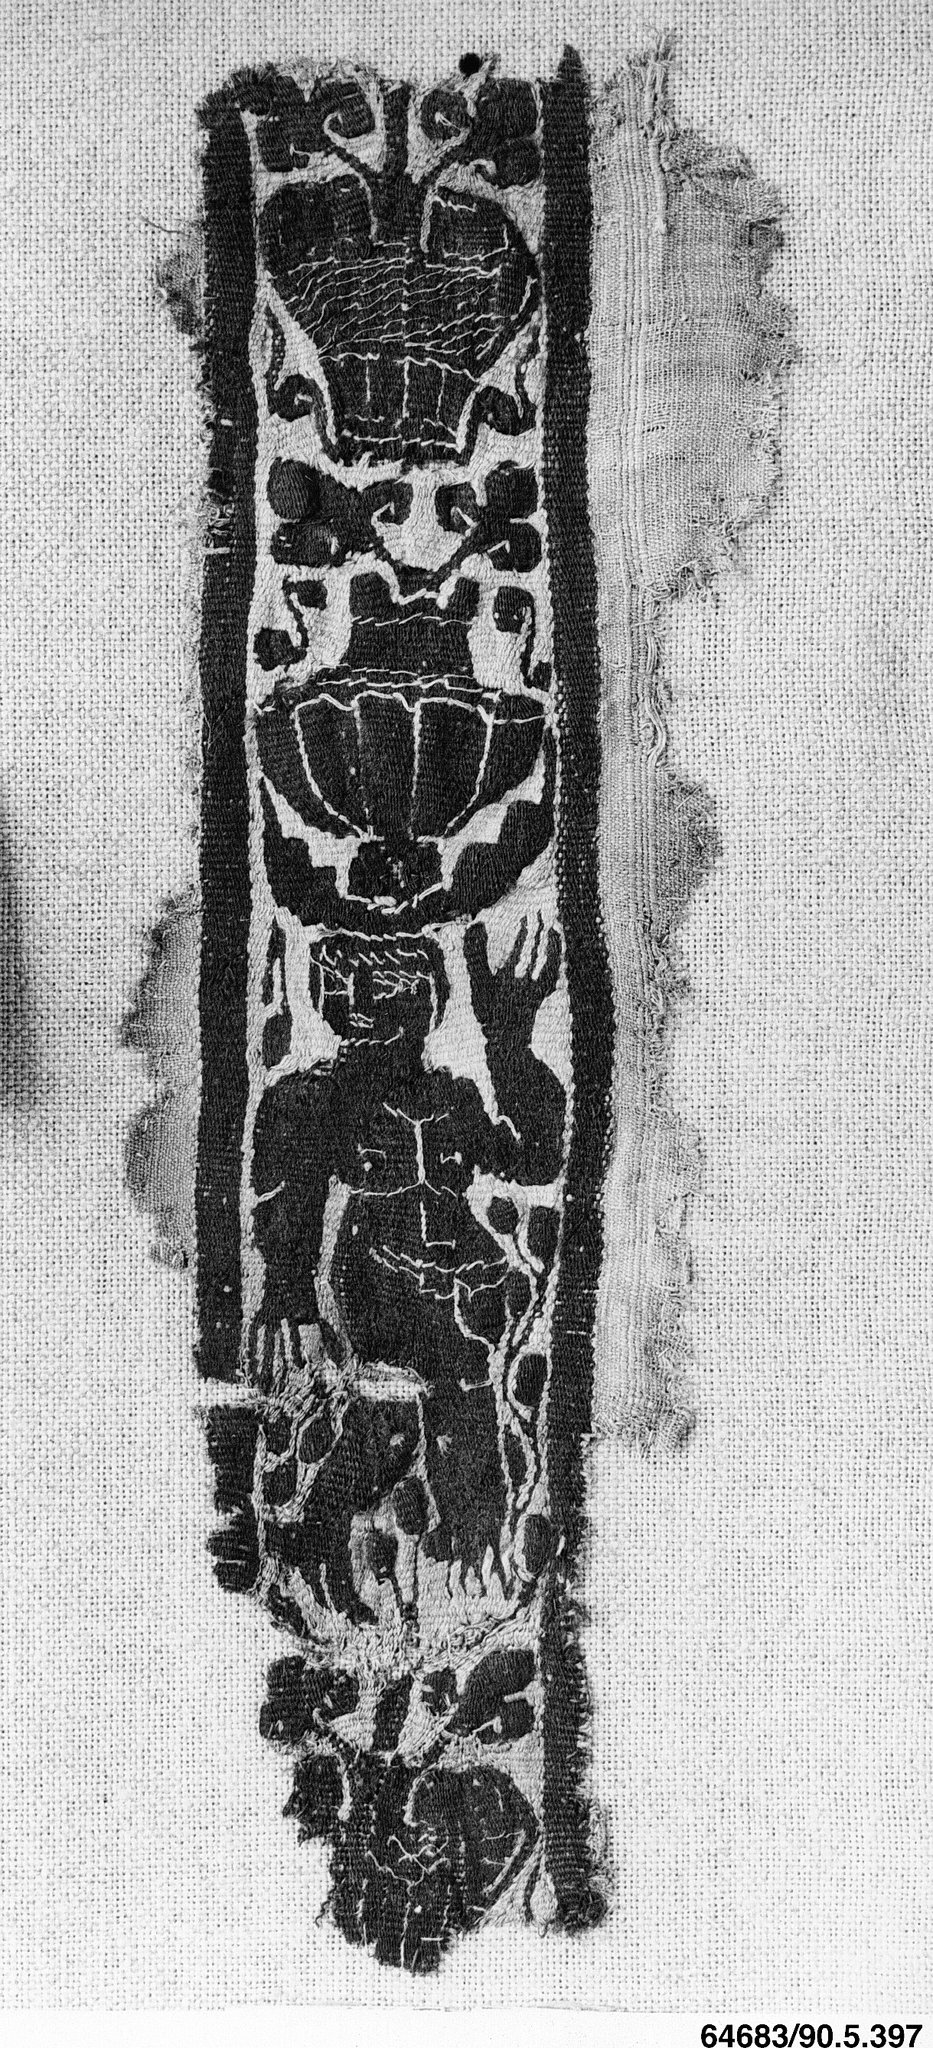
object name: textile fragment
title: Fragment of a Shoulder Band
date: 301-400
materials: linen, wool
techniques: weave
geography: egypt